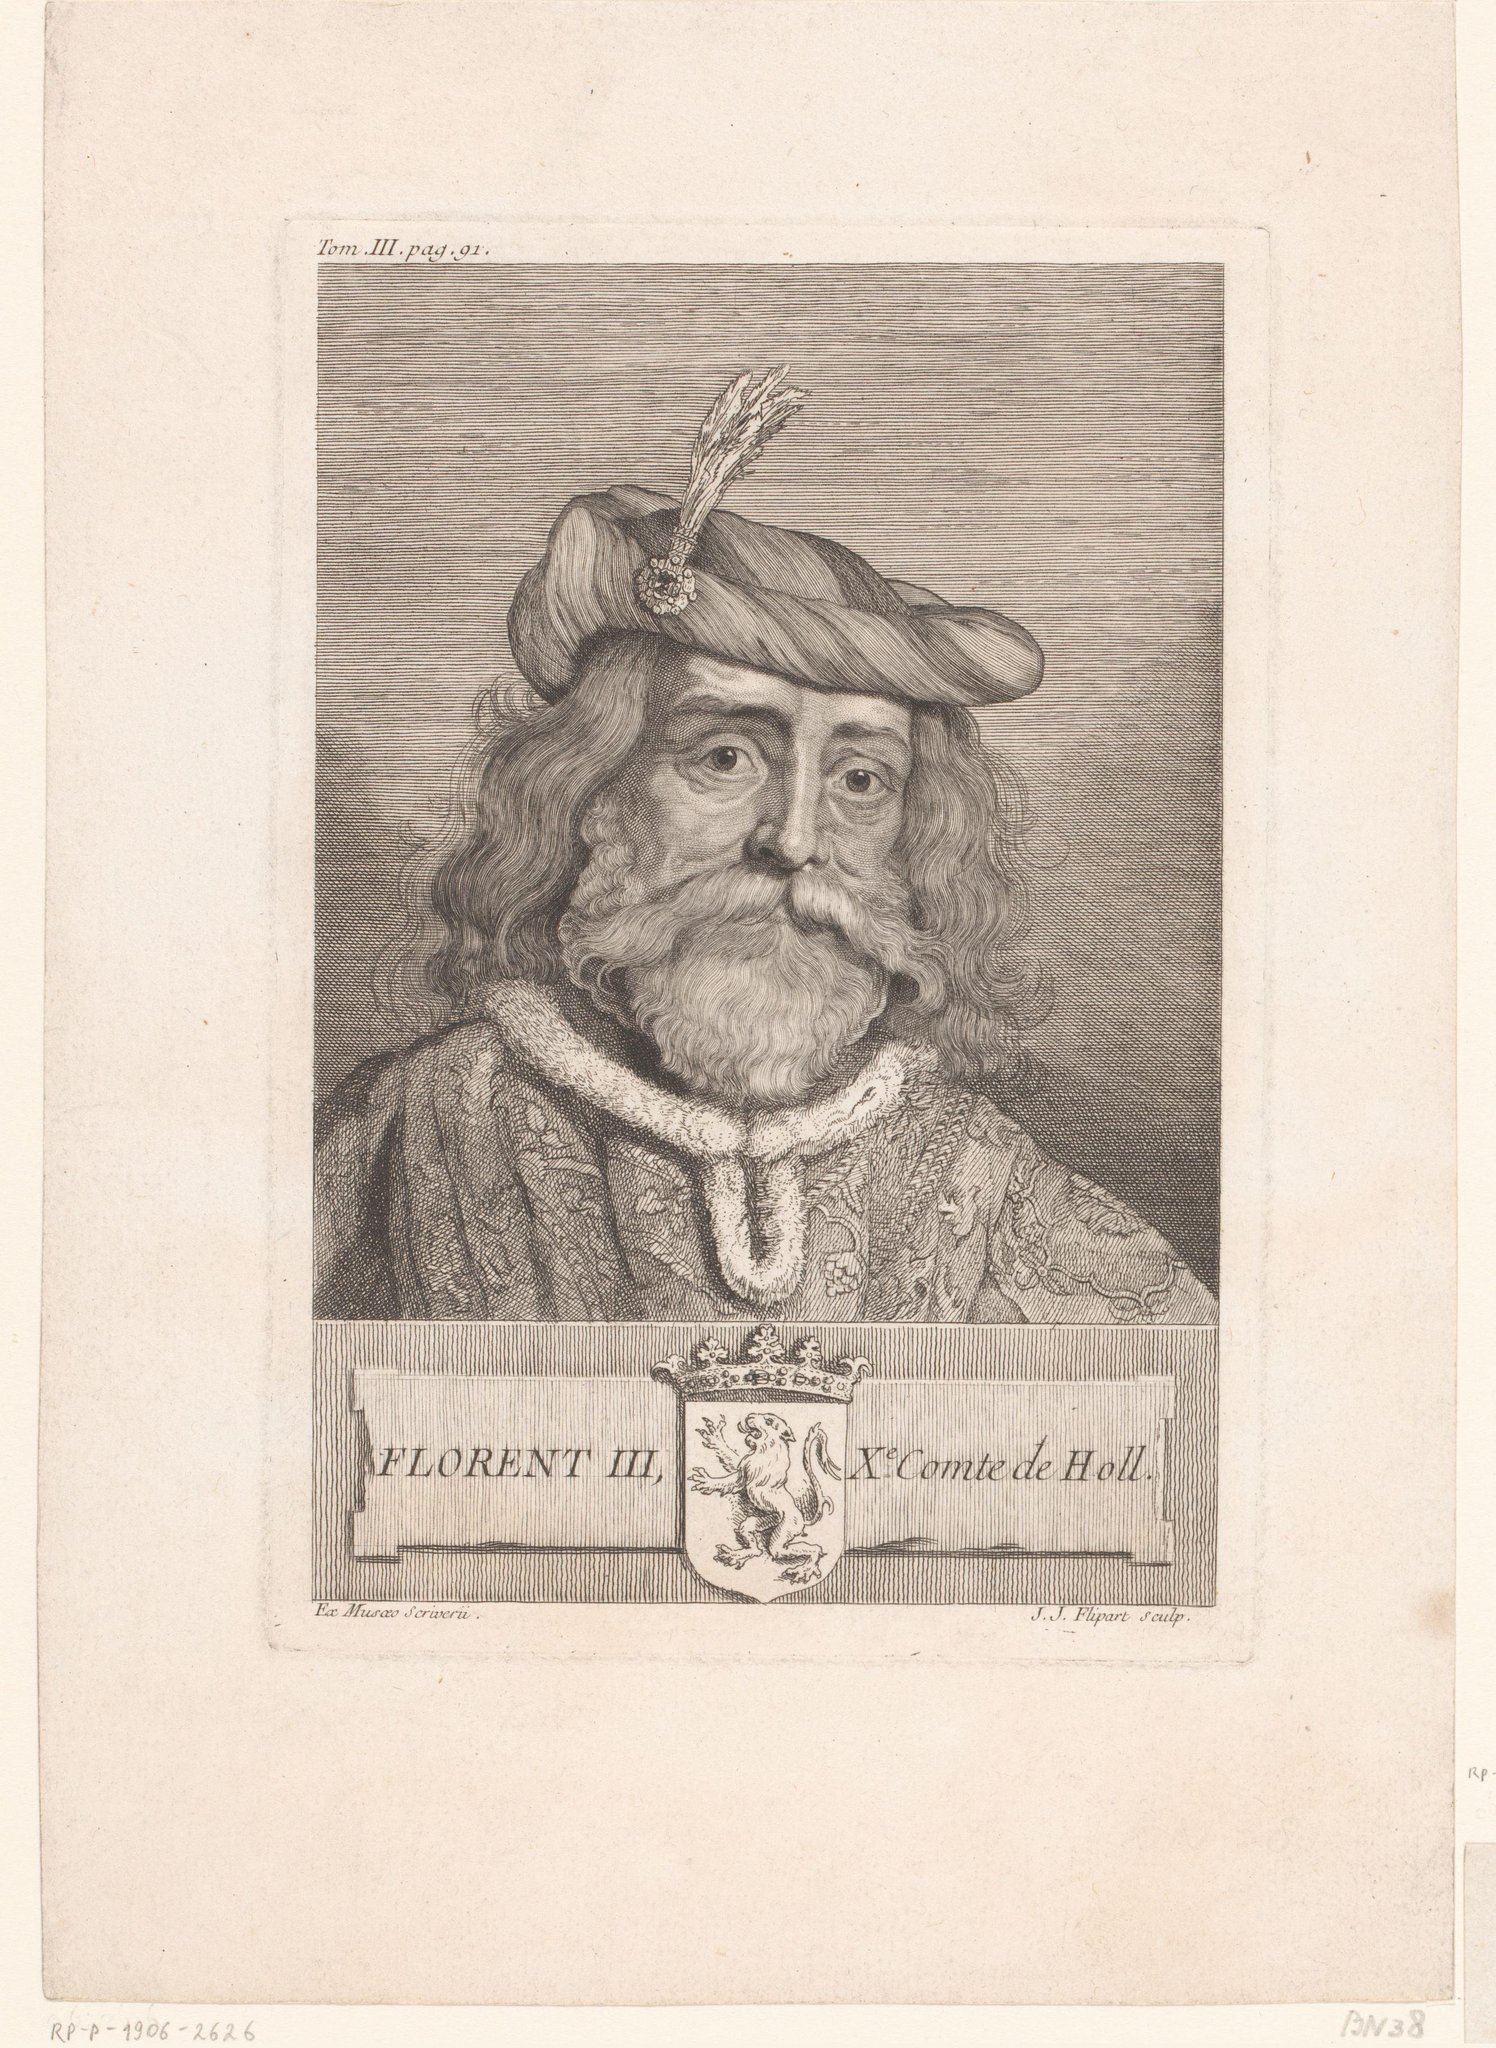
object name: print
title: Portret van Floris III van Holland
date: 1757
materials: paper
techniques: engraving, etching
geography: paris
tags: historical persons, ruler, sovereign, armorial bearing, heraldry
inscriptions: collector's mark: Lugt 2228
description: Prent uit: Sellius en Dujardin. Histoire générale des Provinces-Unies. Parijs: Pierre Guillaume Simon, 1757, dl. 3, p. 91.